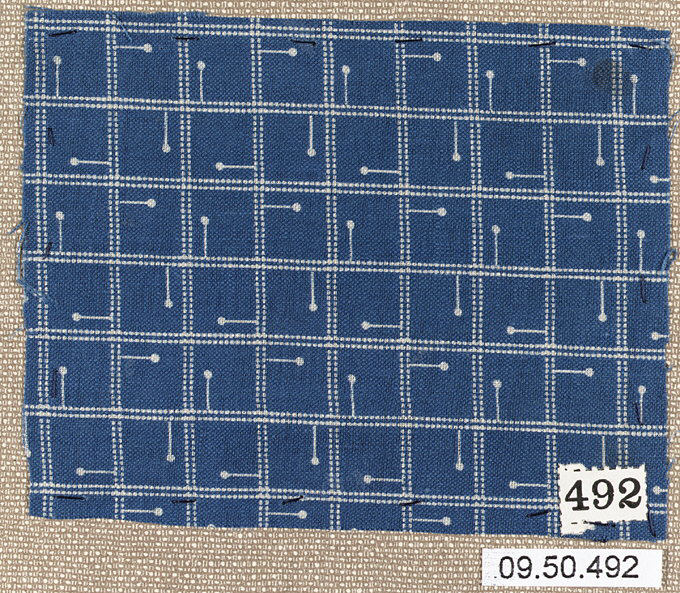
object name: piece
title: Piece (one of 13)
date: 1801-1900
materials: cotton